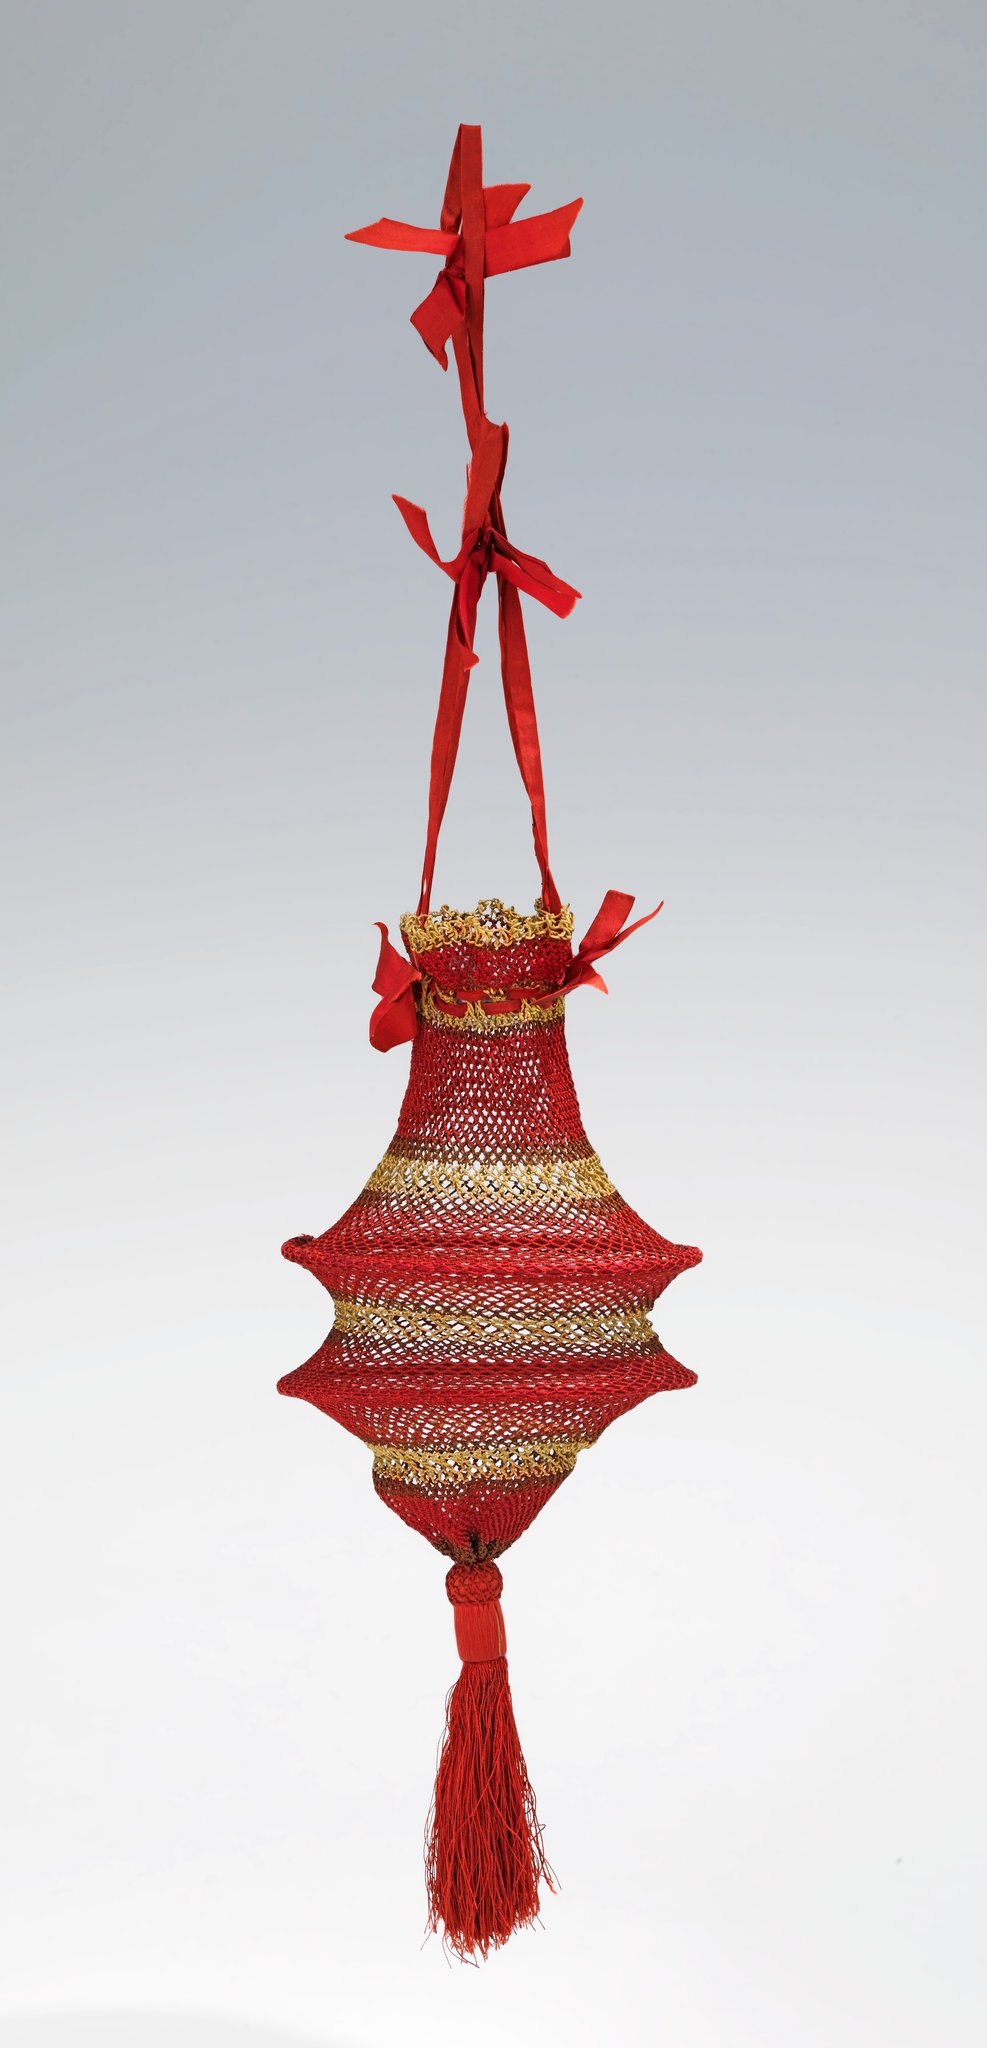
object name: reticule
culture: british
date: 1801-1825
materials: cotton, metal, silk